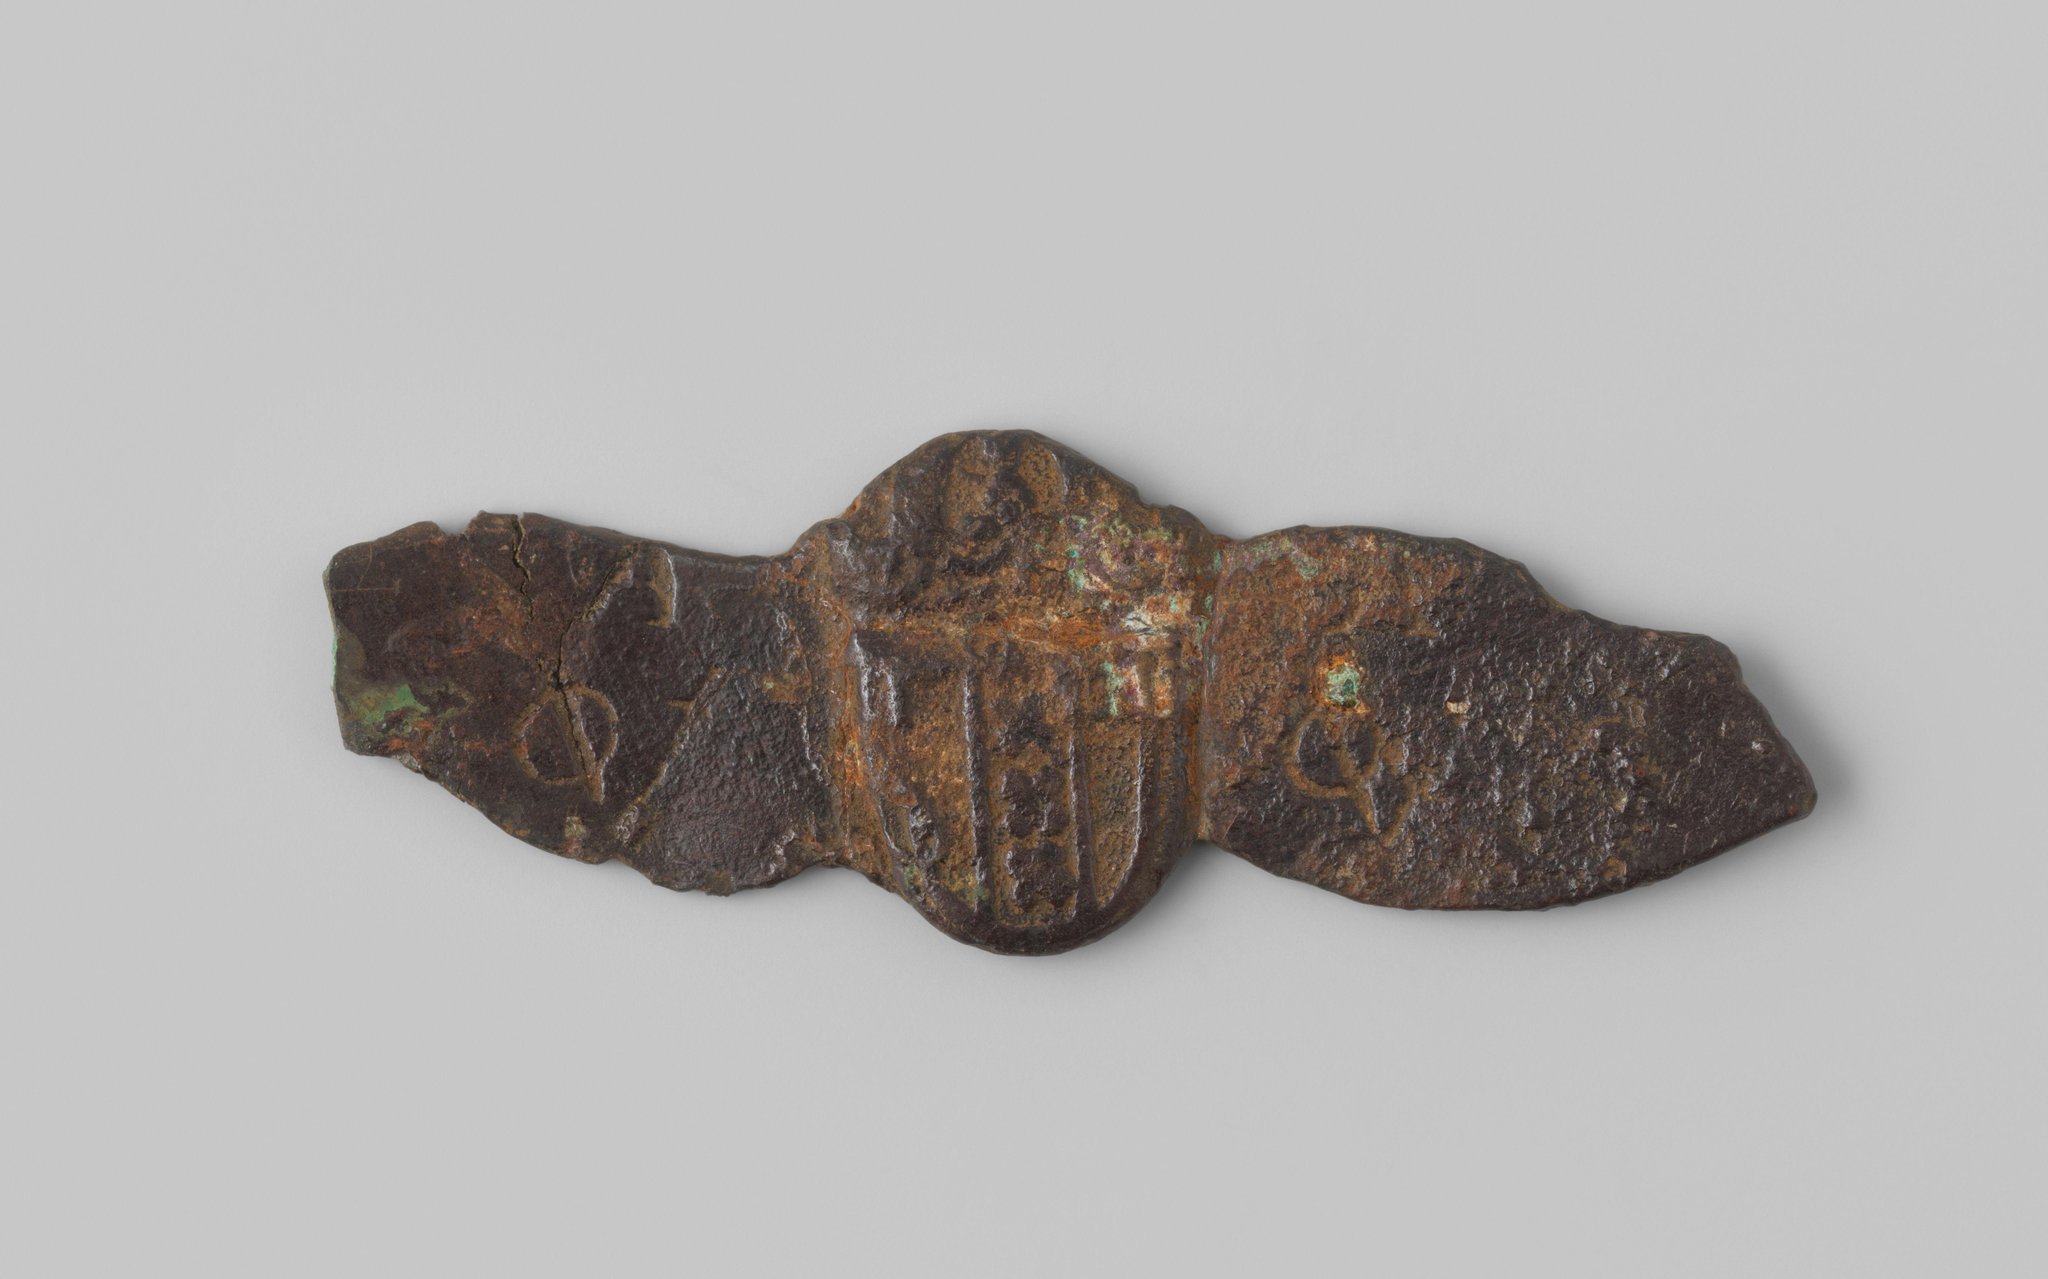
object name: schroefplaat, schroefblik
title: Fragment schroefplaat van een musket uit het wrak van de Oost-Indiëvaarder Hollandia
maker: Anonymous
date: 1700-1743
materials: copper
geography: netherlands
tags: verenigde oostindische compagnie, hollandia (schip), annet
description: Fragm, id. NG 1978-74H986 or NG 1980-27H3069, eyes broken off, side plate.